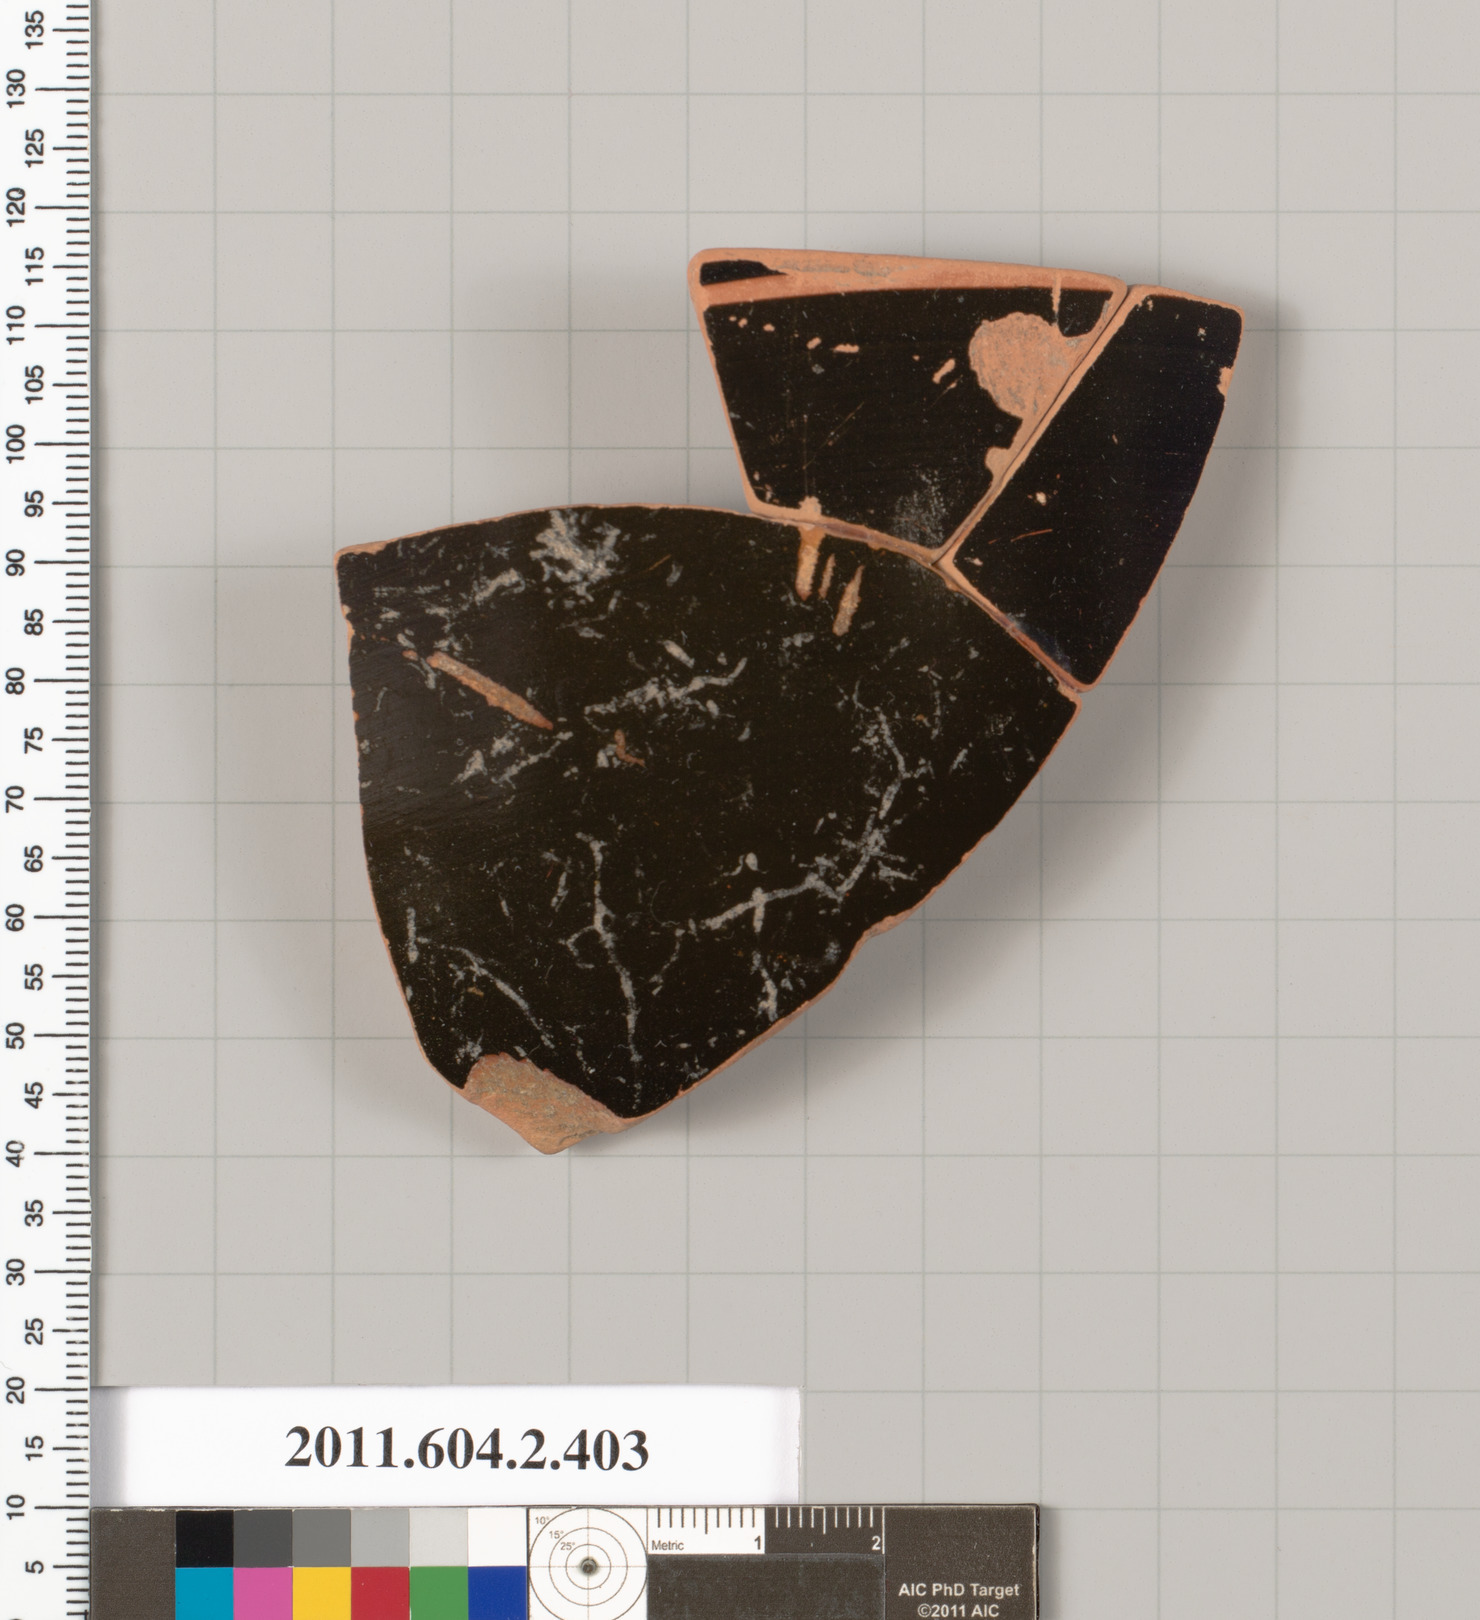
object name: column krater fragment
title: Terracotta fragment of a column-krater (bowl for mixing wine and water)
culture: greek, attic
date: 475-451 BCE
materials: terracotta